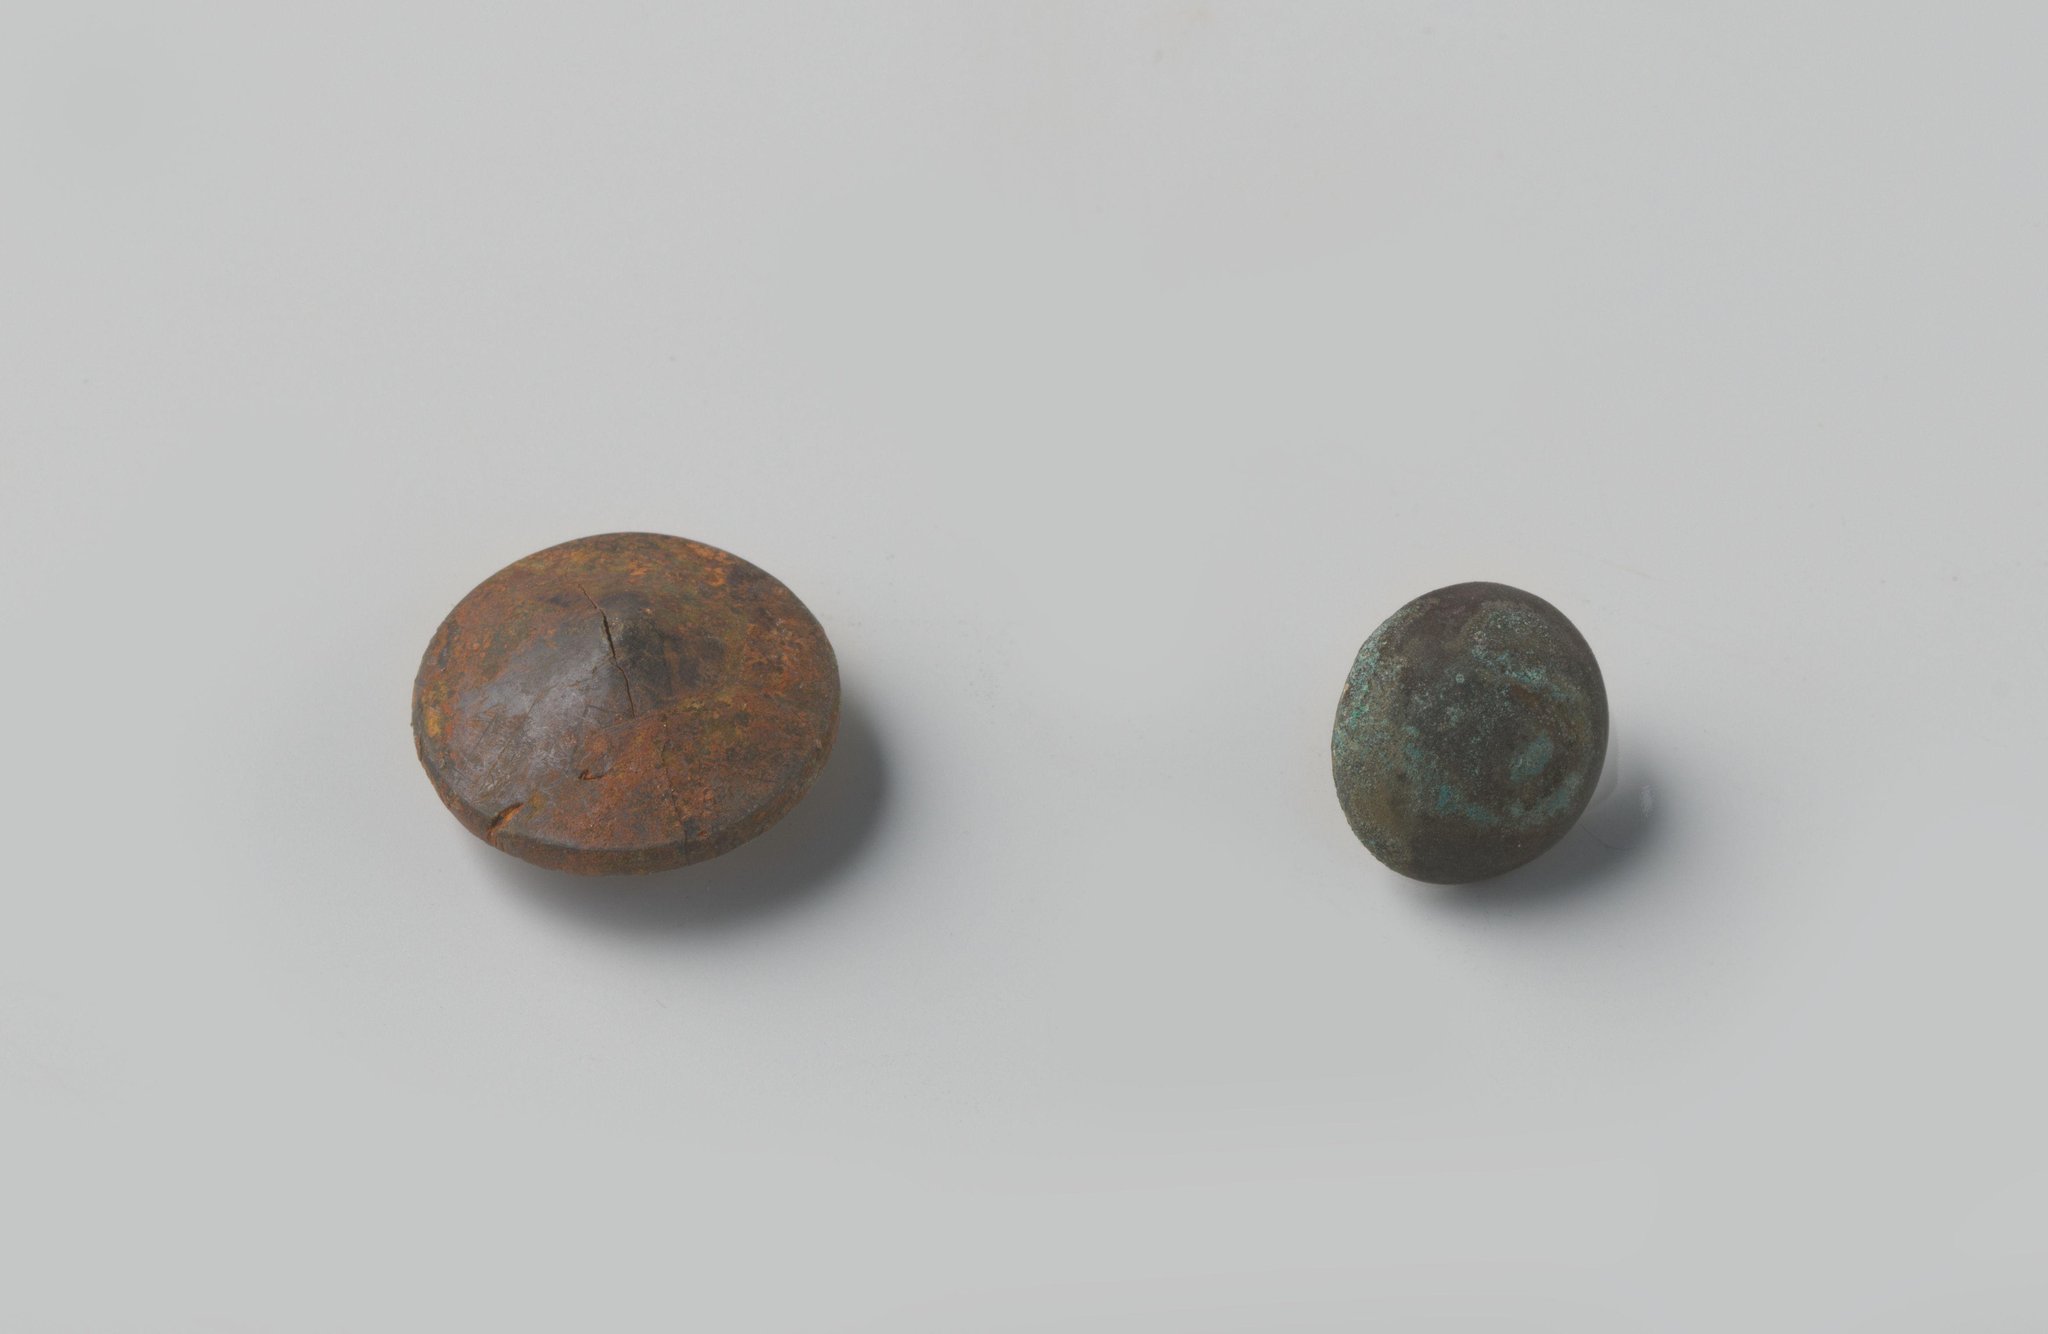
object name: button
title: Knopen uit het wrak van de Oostindiëvaarder Hollandia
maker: Anonymous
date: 1700-1743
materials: bronze, wood